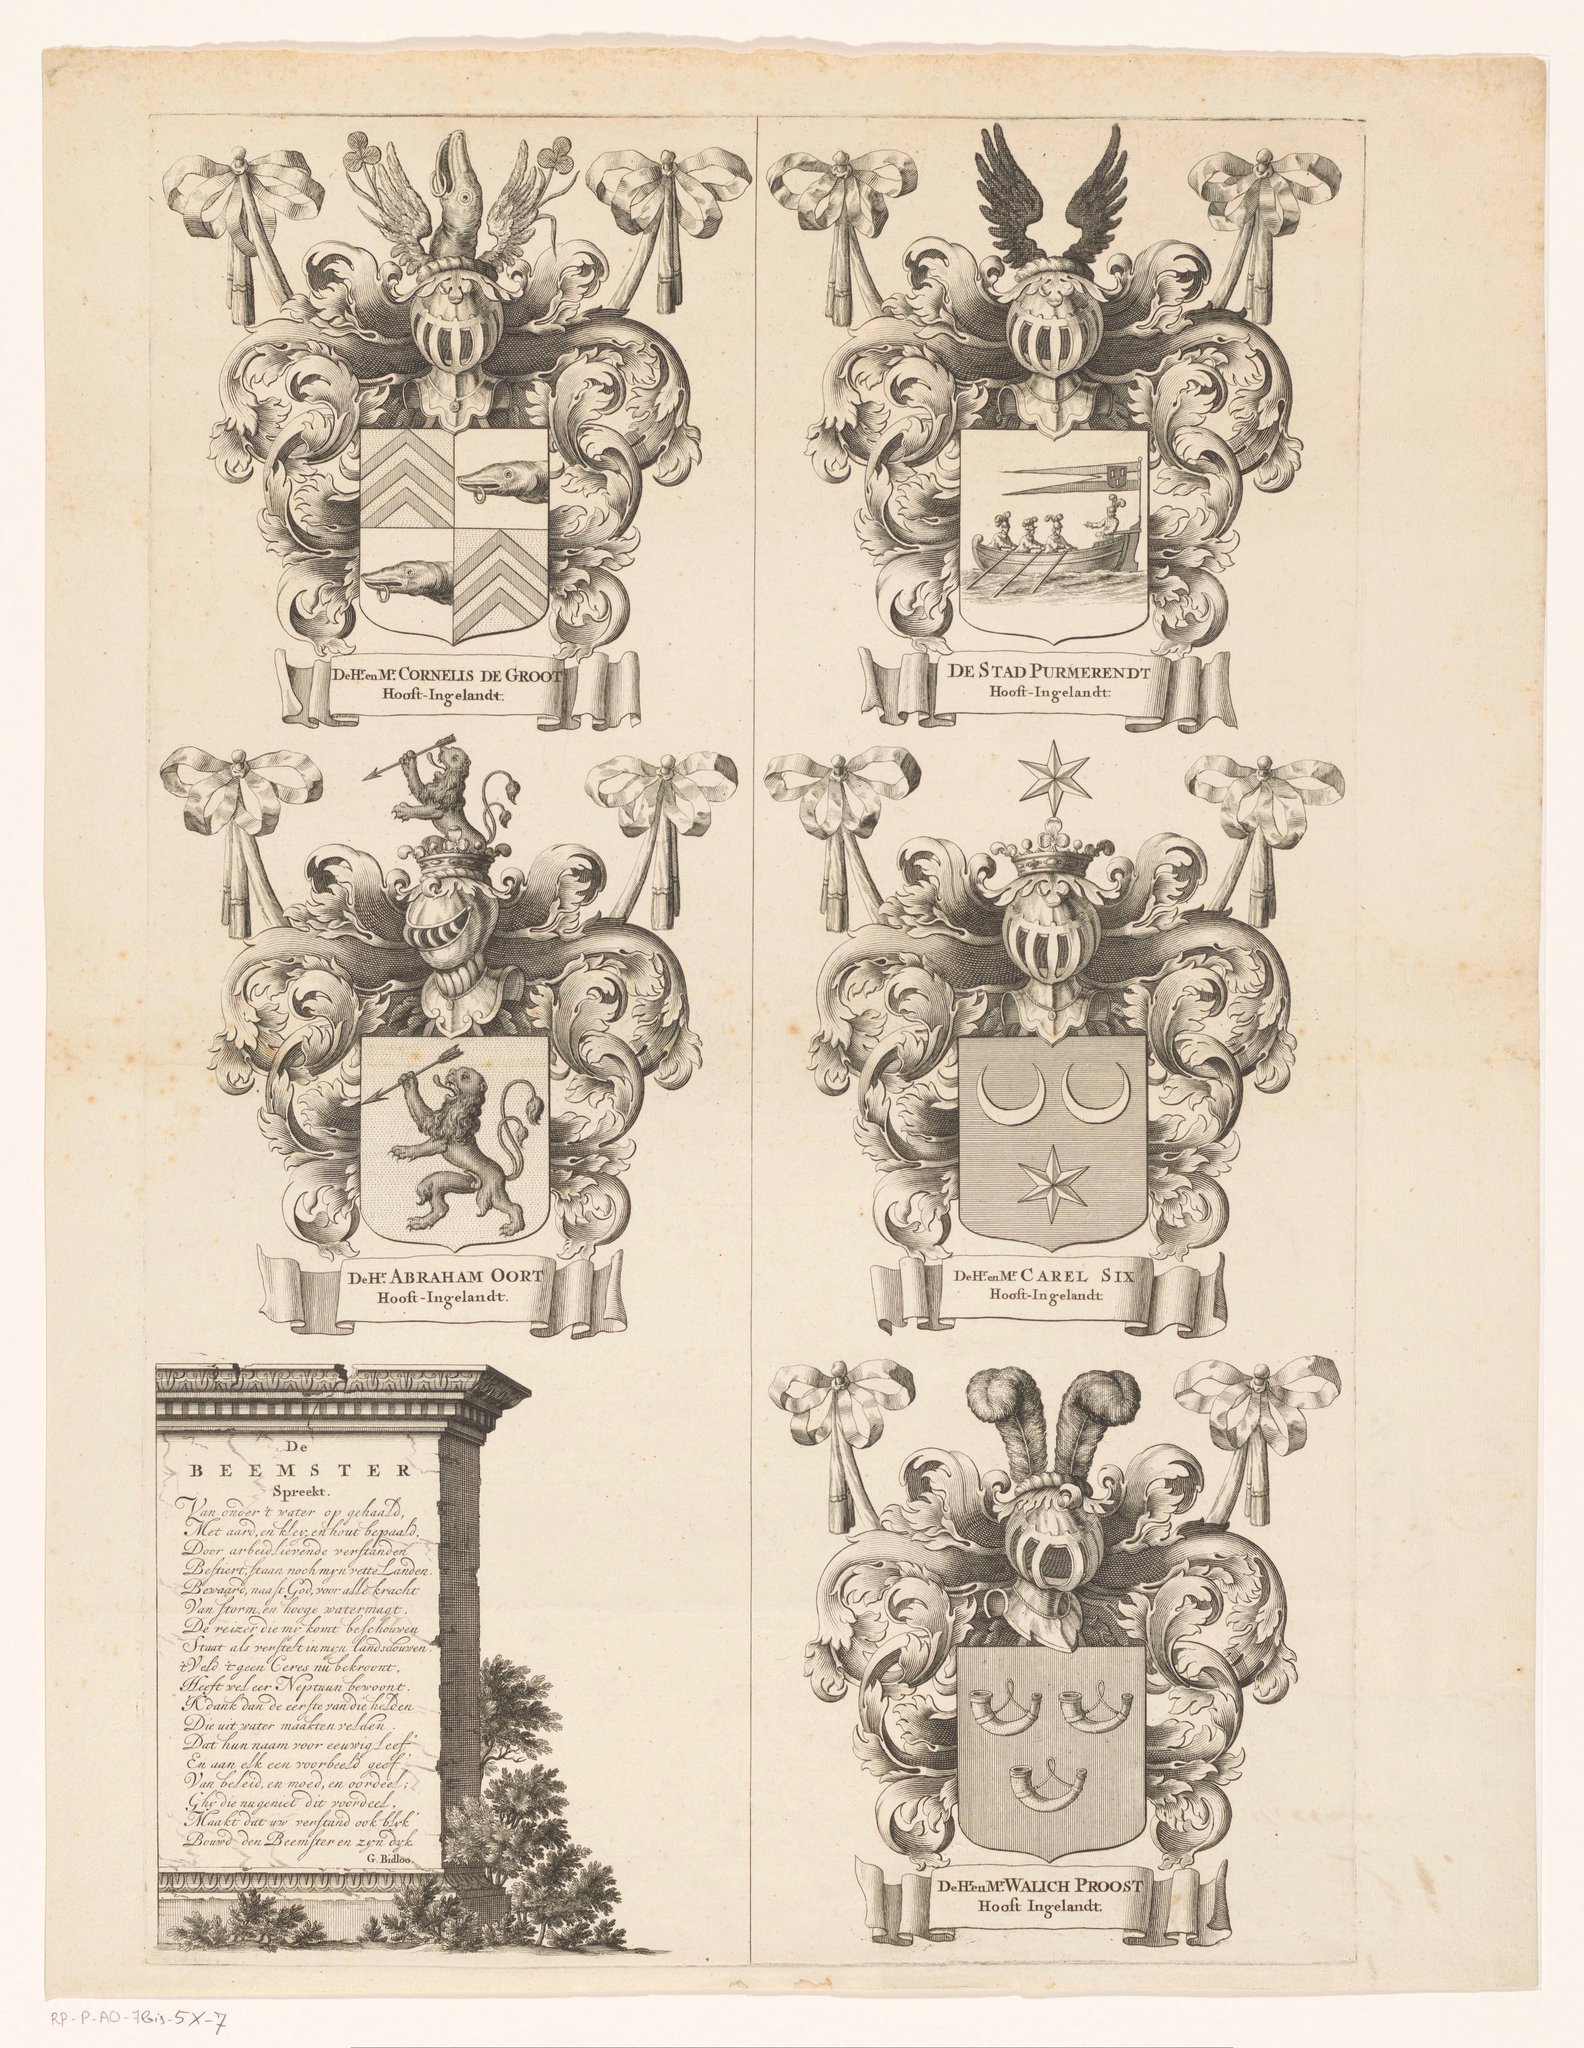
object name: print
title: Blad voor sierrand bij een kaart van de Beemster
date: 1685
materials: paper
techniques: engraving, etching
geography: amsterdam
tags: coat of arms (as symbol of the state, etc.), polder, reclaimed land, armorial bearing, heraldry, beemster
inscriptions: collector's mark: Lugt 19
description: Dit blad is onderdeel van een sierrand die hoort bij een kaart van de Beemster die in 1685 werd uitgegeven (RP-P-AO-7bis-5X). De sierrand werd gedrukt op verschillende bladen en bestond uit een nieuwe titel (die over de oude titel geplakt kon worden), een Nederlands gedicht van Govard Bidloo en 28 wapenschilden van de (hoofd)ingelanden, dijkgraaf, hoogheemraden en secretaris van de Beemster. In de collectie van het Rijksmuseum is slechts dit blad van de sierrand te vinden.